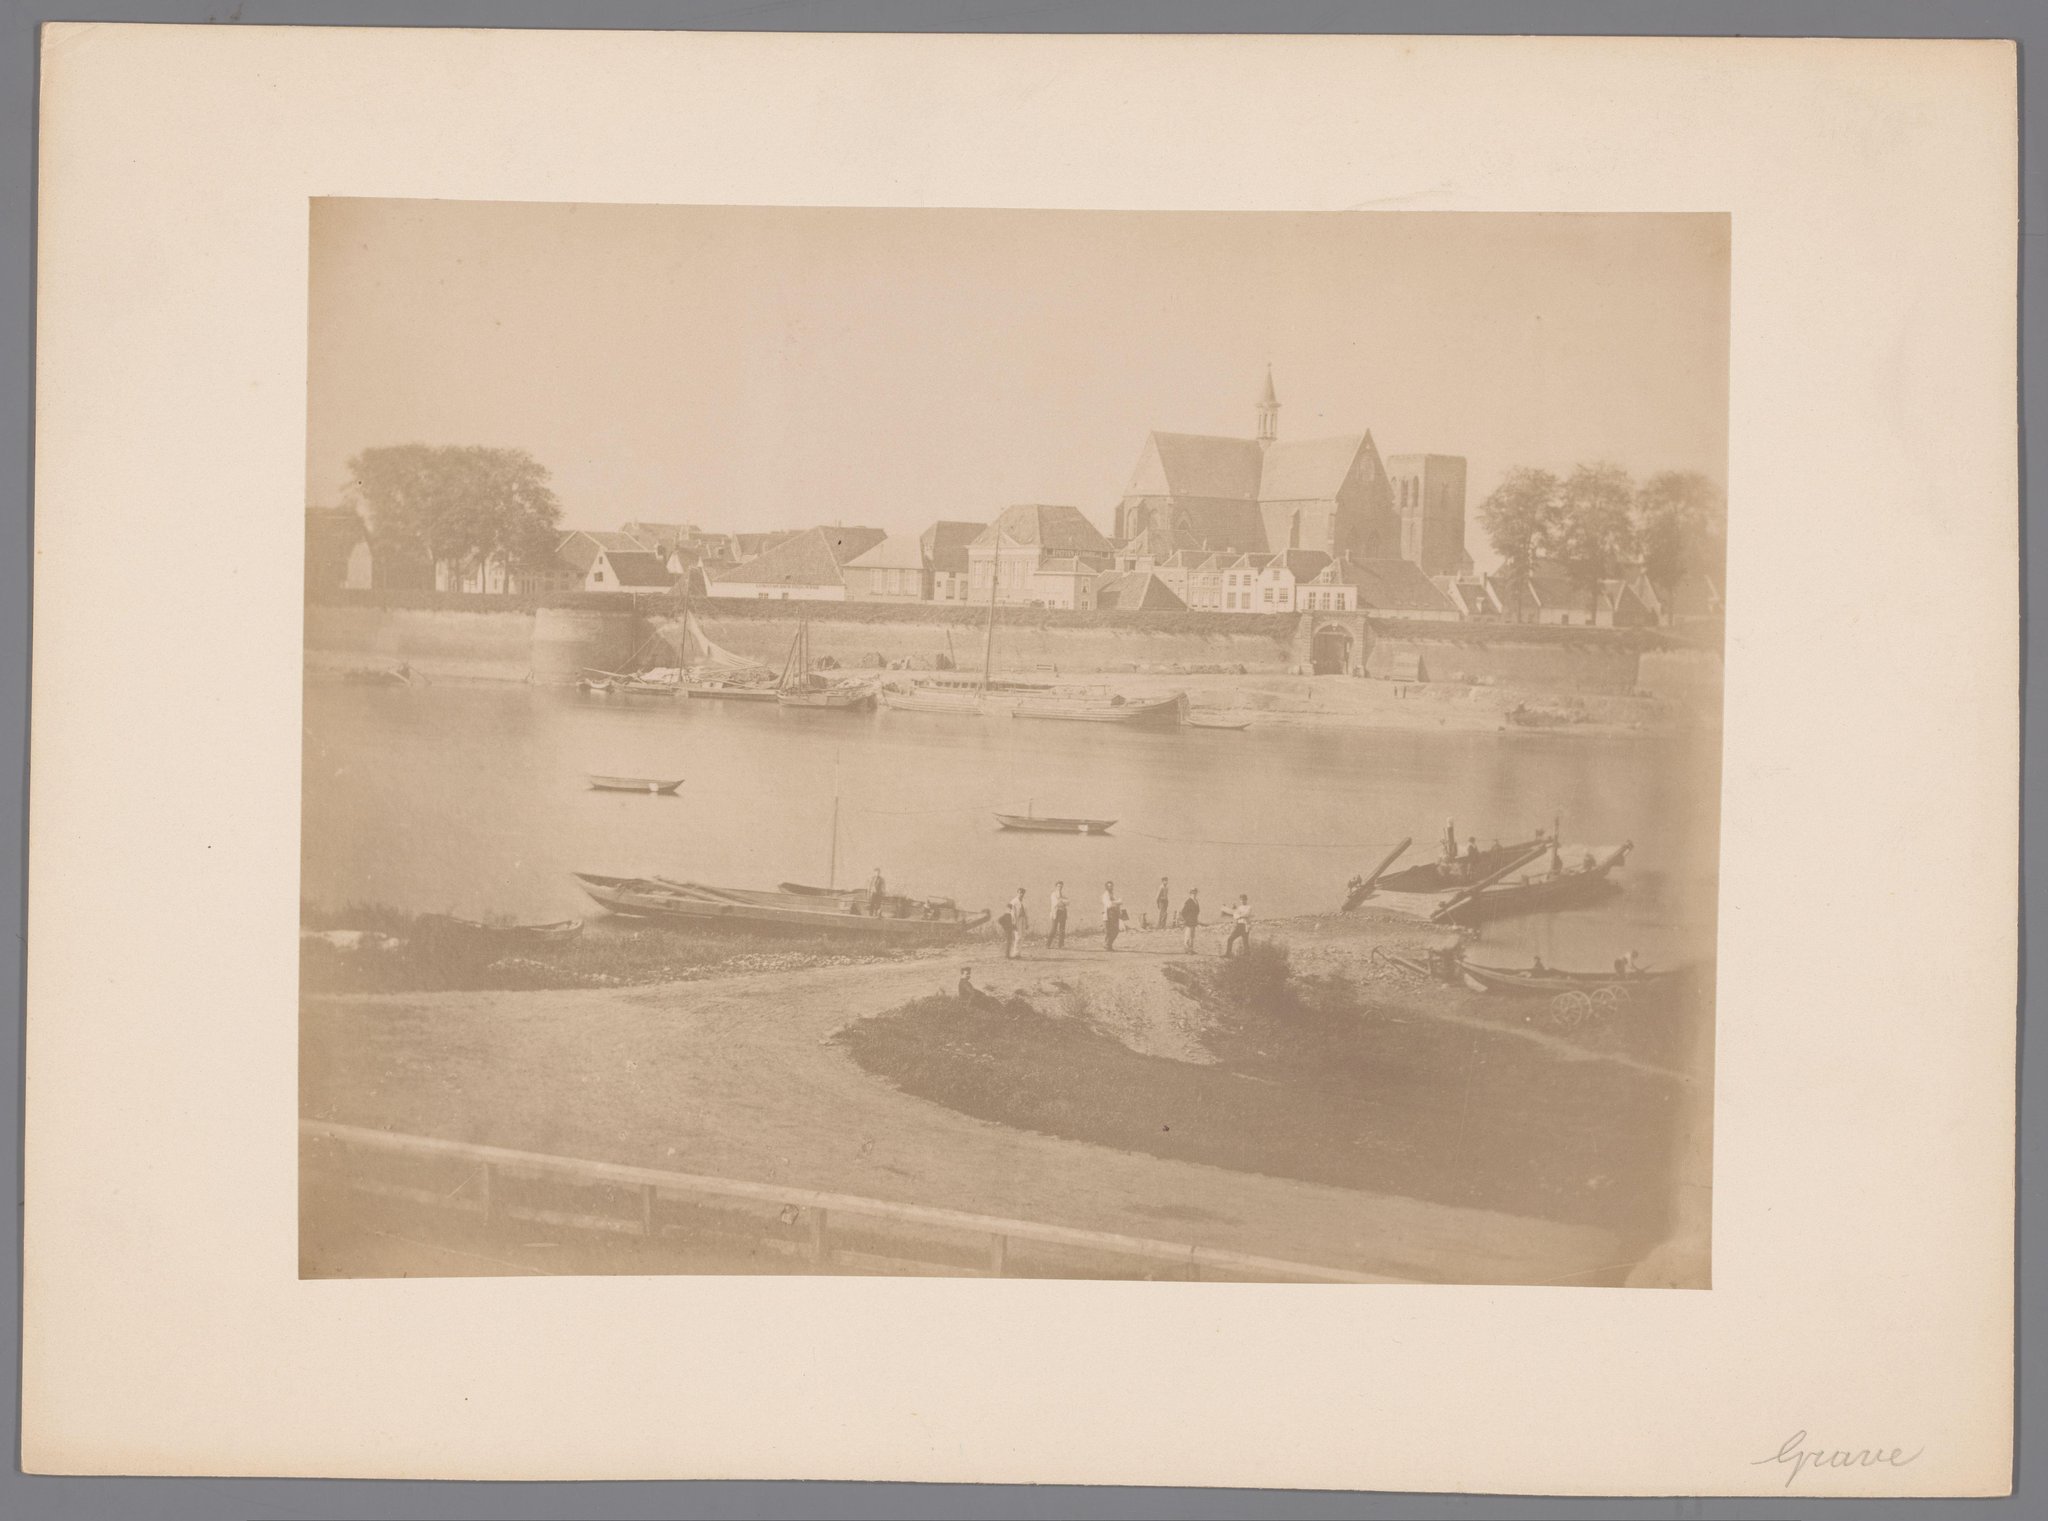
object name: photograph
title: Gezicht op Grave met de Sint-Elisabethkerk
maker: anoniem (monumentenzorg)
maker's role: fotograaf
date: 1890-1920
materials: cardboard, photographic support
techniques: albumen print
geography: grave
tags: church (exterior), street (+ city(-scape) with figures, staffage), grave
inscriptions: annotation: ‘Grave’, annotation: ‘Grave/ gezicht op de stad voo de sloping der wallen’